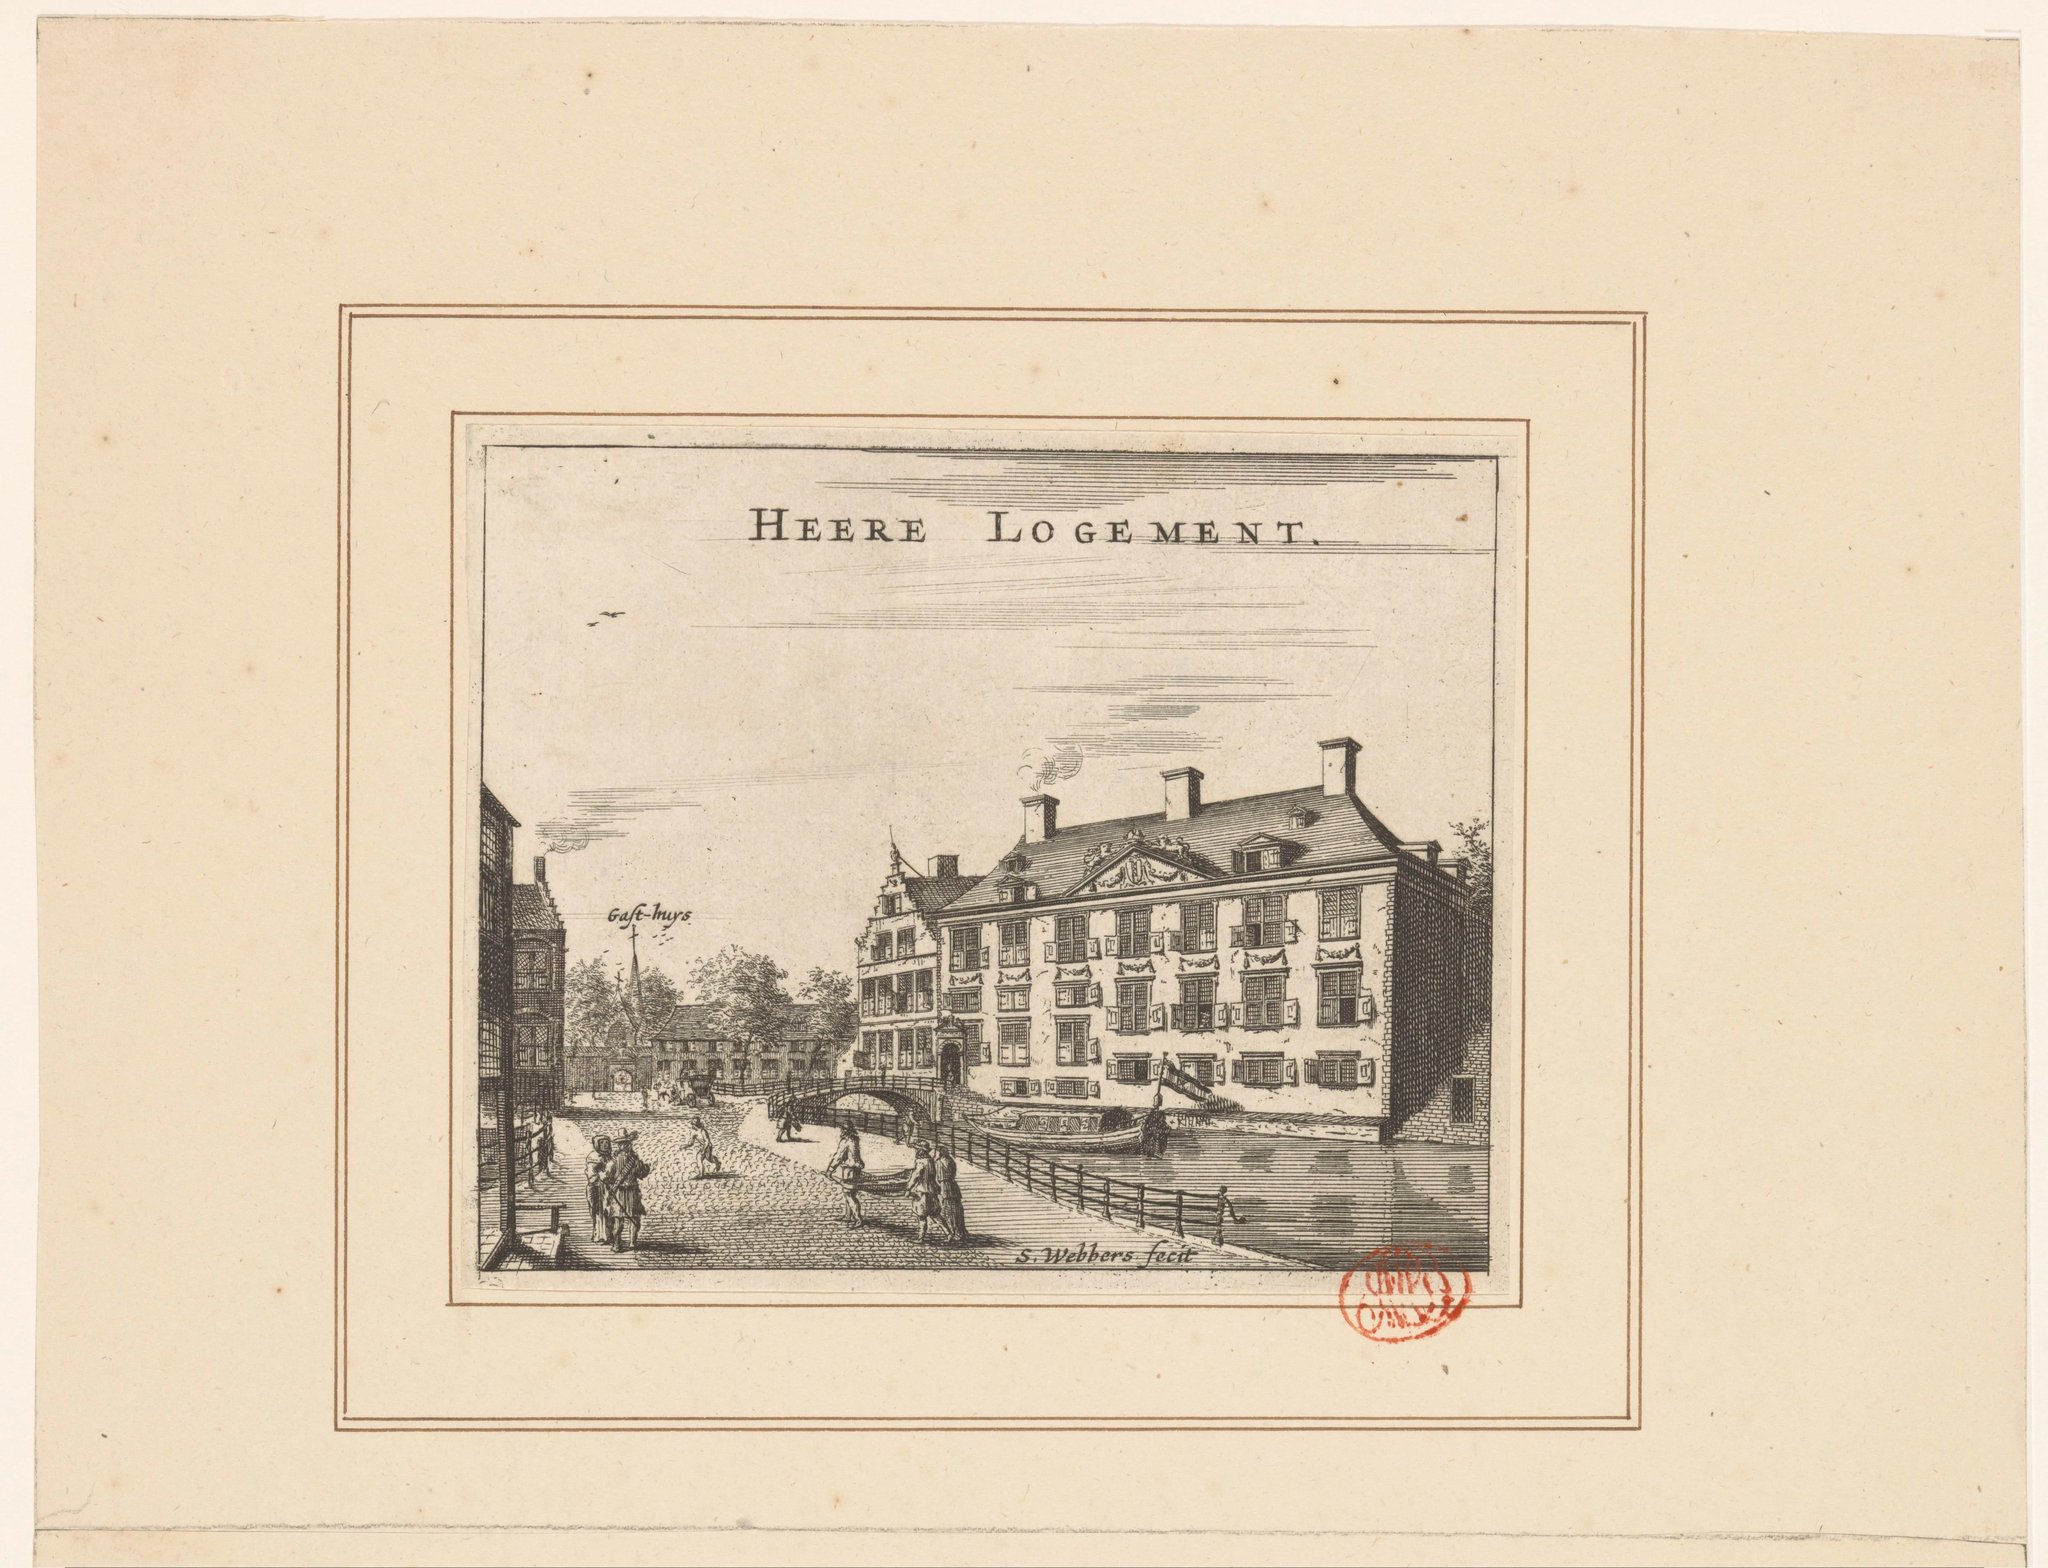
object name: print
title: Heere Logement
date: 1664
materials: paper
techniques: engraving, etching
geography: amsterdam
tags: hotel, hostelry, inn, canals, waters (in city) (+ city(-scape) with figures, staffage), street (+ city(-scape) with figures, staffage)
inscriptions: collector's mark: Lugt 195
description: Huidige staat van prent ook gebruikt in: Fockens, Melchior. Beschrijving Der wijdt-vermaarde Koop-stadt Amstelredam, Van haar eerste beginselen, zedert den Jare 1203. oude Voorrechten, verscheyde Vergrootingenoude Voor-rechten, en verscheyde Vergrootingen (…). 3e druk. Amsterdam: Marcus Willemsz. Doornick, 1664. En in: Zesen, Philipp von. Beschrybung der Weidtberuhmde Kauf-Stadt Amstelredam / Beschreibung der Stadt Amsterdam darinnen von derselben ersten ursprunge bis auf gegenwartigen zustand (…). Amsterdam: Marcus Willemsz. Doornick, 1664. Eerste bekende staat van prent (linksboven genummerd: 256) ook gebruikt in: Fockens, Melchior. Beschrijvinge Der wijdt-vermaarde Koop-stadt Amstelredam, Van hare eerste beginselen, oude Voor-rechten, en verscheyde Vergrootingen (…). 1e druk. Amsterdam: Marcus Willemsz. Doornick, 1662. En in: Fockens, Melchior. Beschrijvinge Der wijdt-vermaarde Koop-stadt Amstelredam, Van hare eerste beginselen, oude Voor-rechten, en verscheyde Vergrootingen (…). 2e druk. Amsterdam: Marcus Willemsz. Doornick, 1662. Derde bekende staat (met toevoeging Franse titel) ook gebruikt in: Domselaer, Tobias en Isaac Commelin. Beschryvinge van Amsterdam : haar eerste oorspronk uyt den huyze der heeren van Aemstel en Aemstellant (…). 6 delen. Amsterdam: Marcus Willemsz van Doornick, 1665. Vierde bekende staat (rechtsboven genummerd: 45) ook gebruikt in verschillende latere zeventiende- en achttiende-eeuwse publicaties.